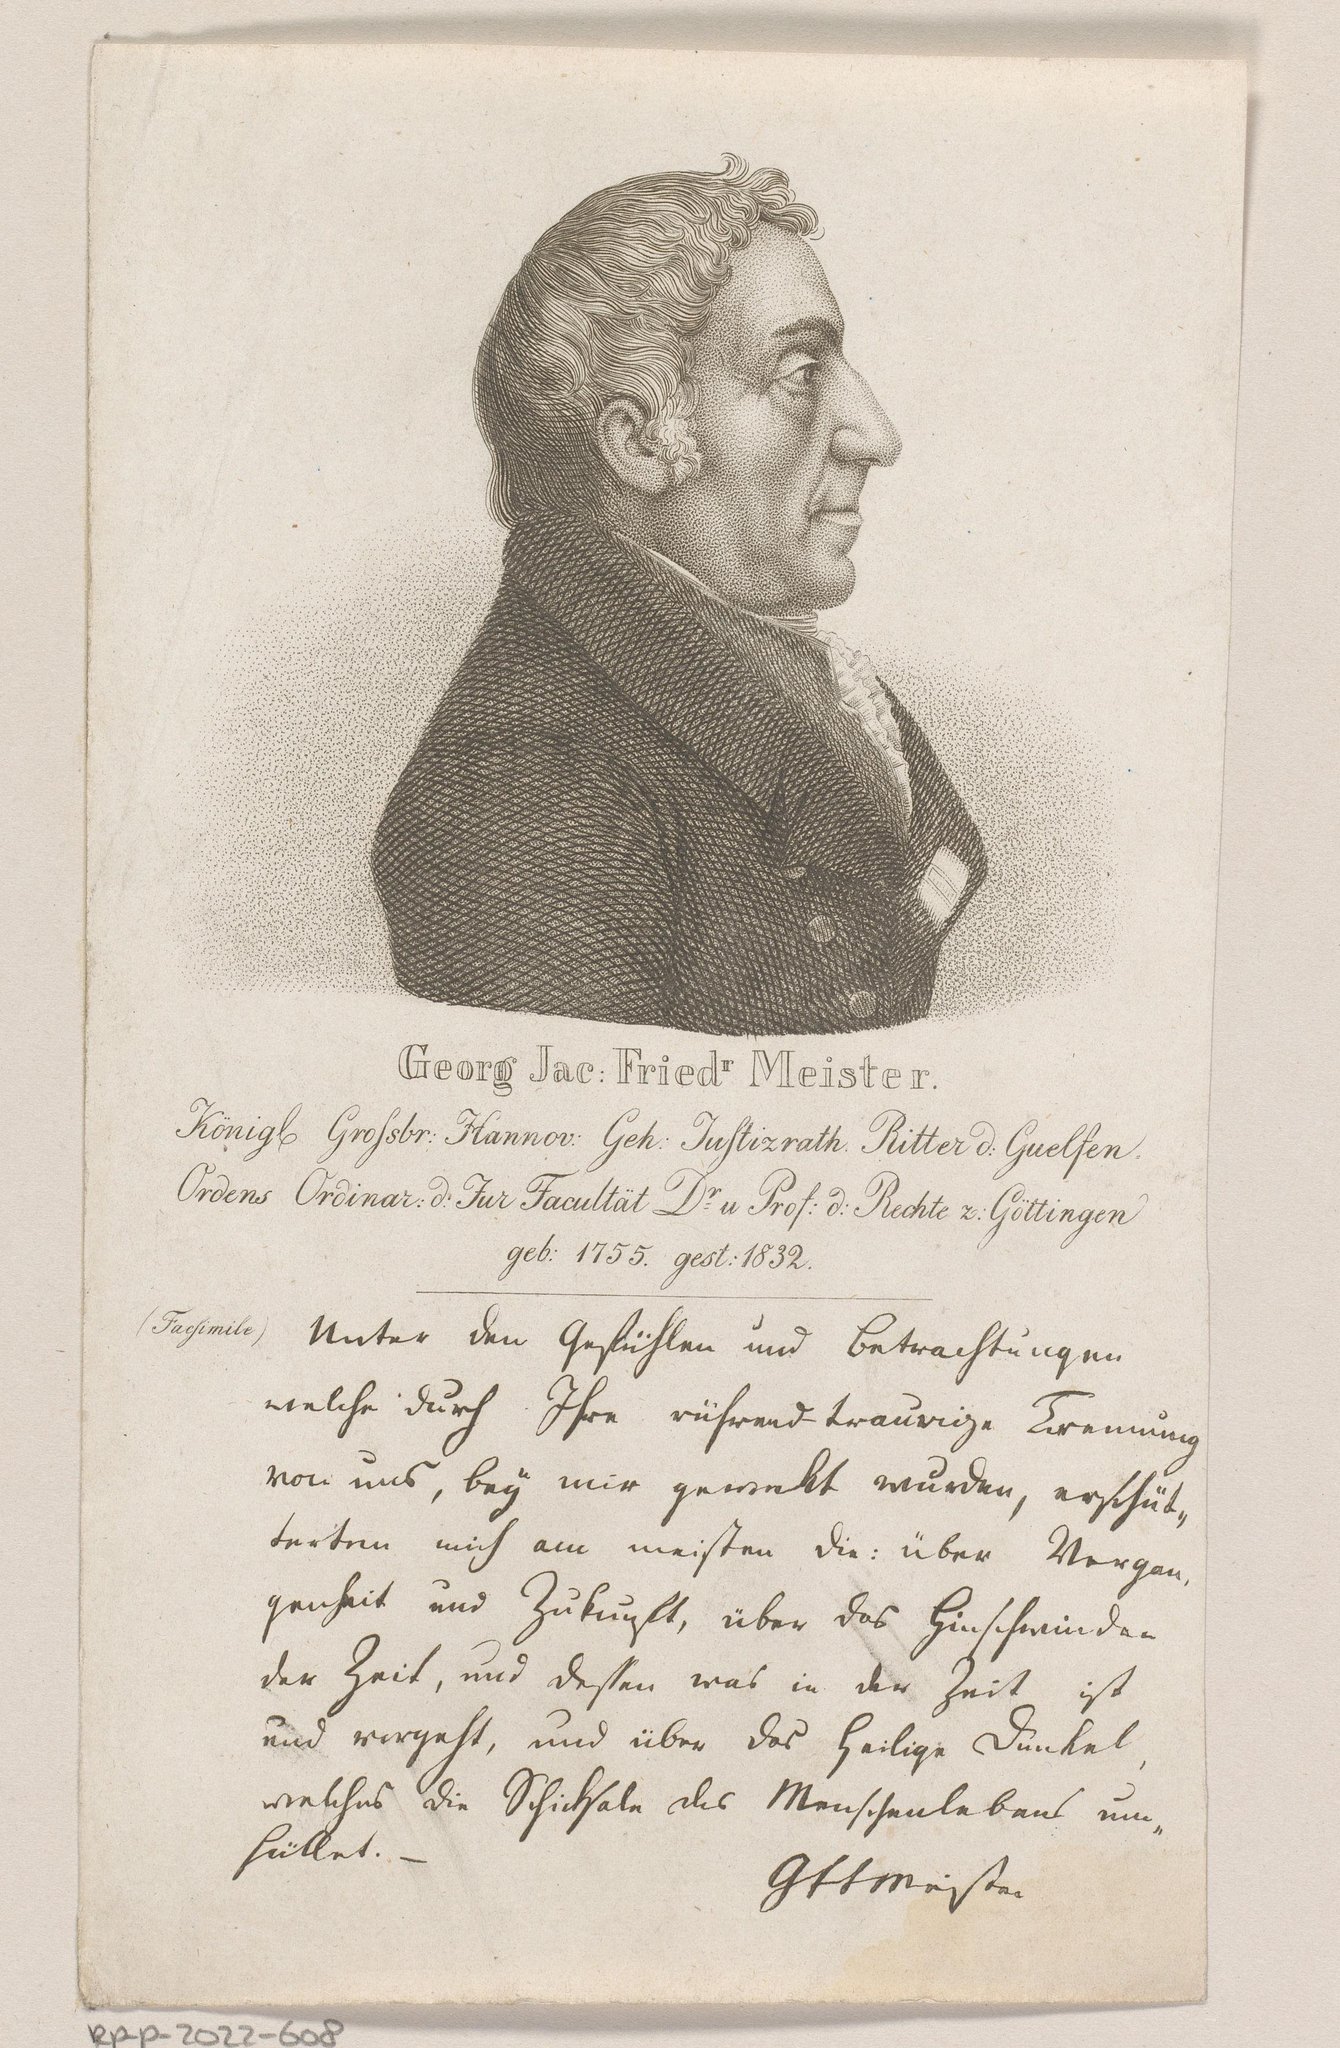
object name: print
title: Portret van Georg Jacob Friedrich Meister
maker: Anonymous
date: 1832-1900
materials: paper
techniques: engraving, etching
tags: historical persons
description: Met facsimile handschrift en drieregelig onderschrift in het Duits.